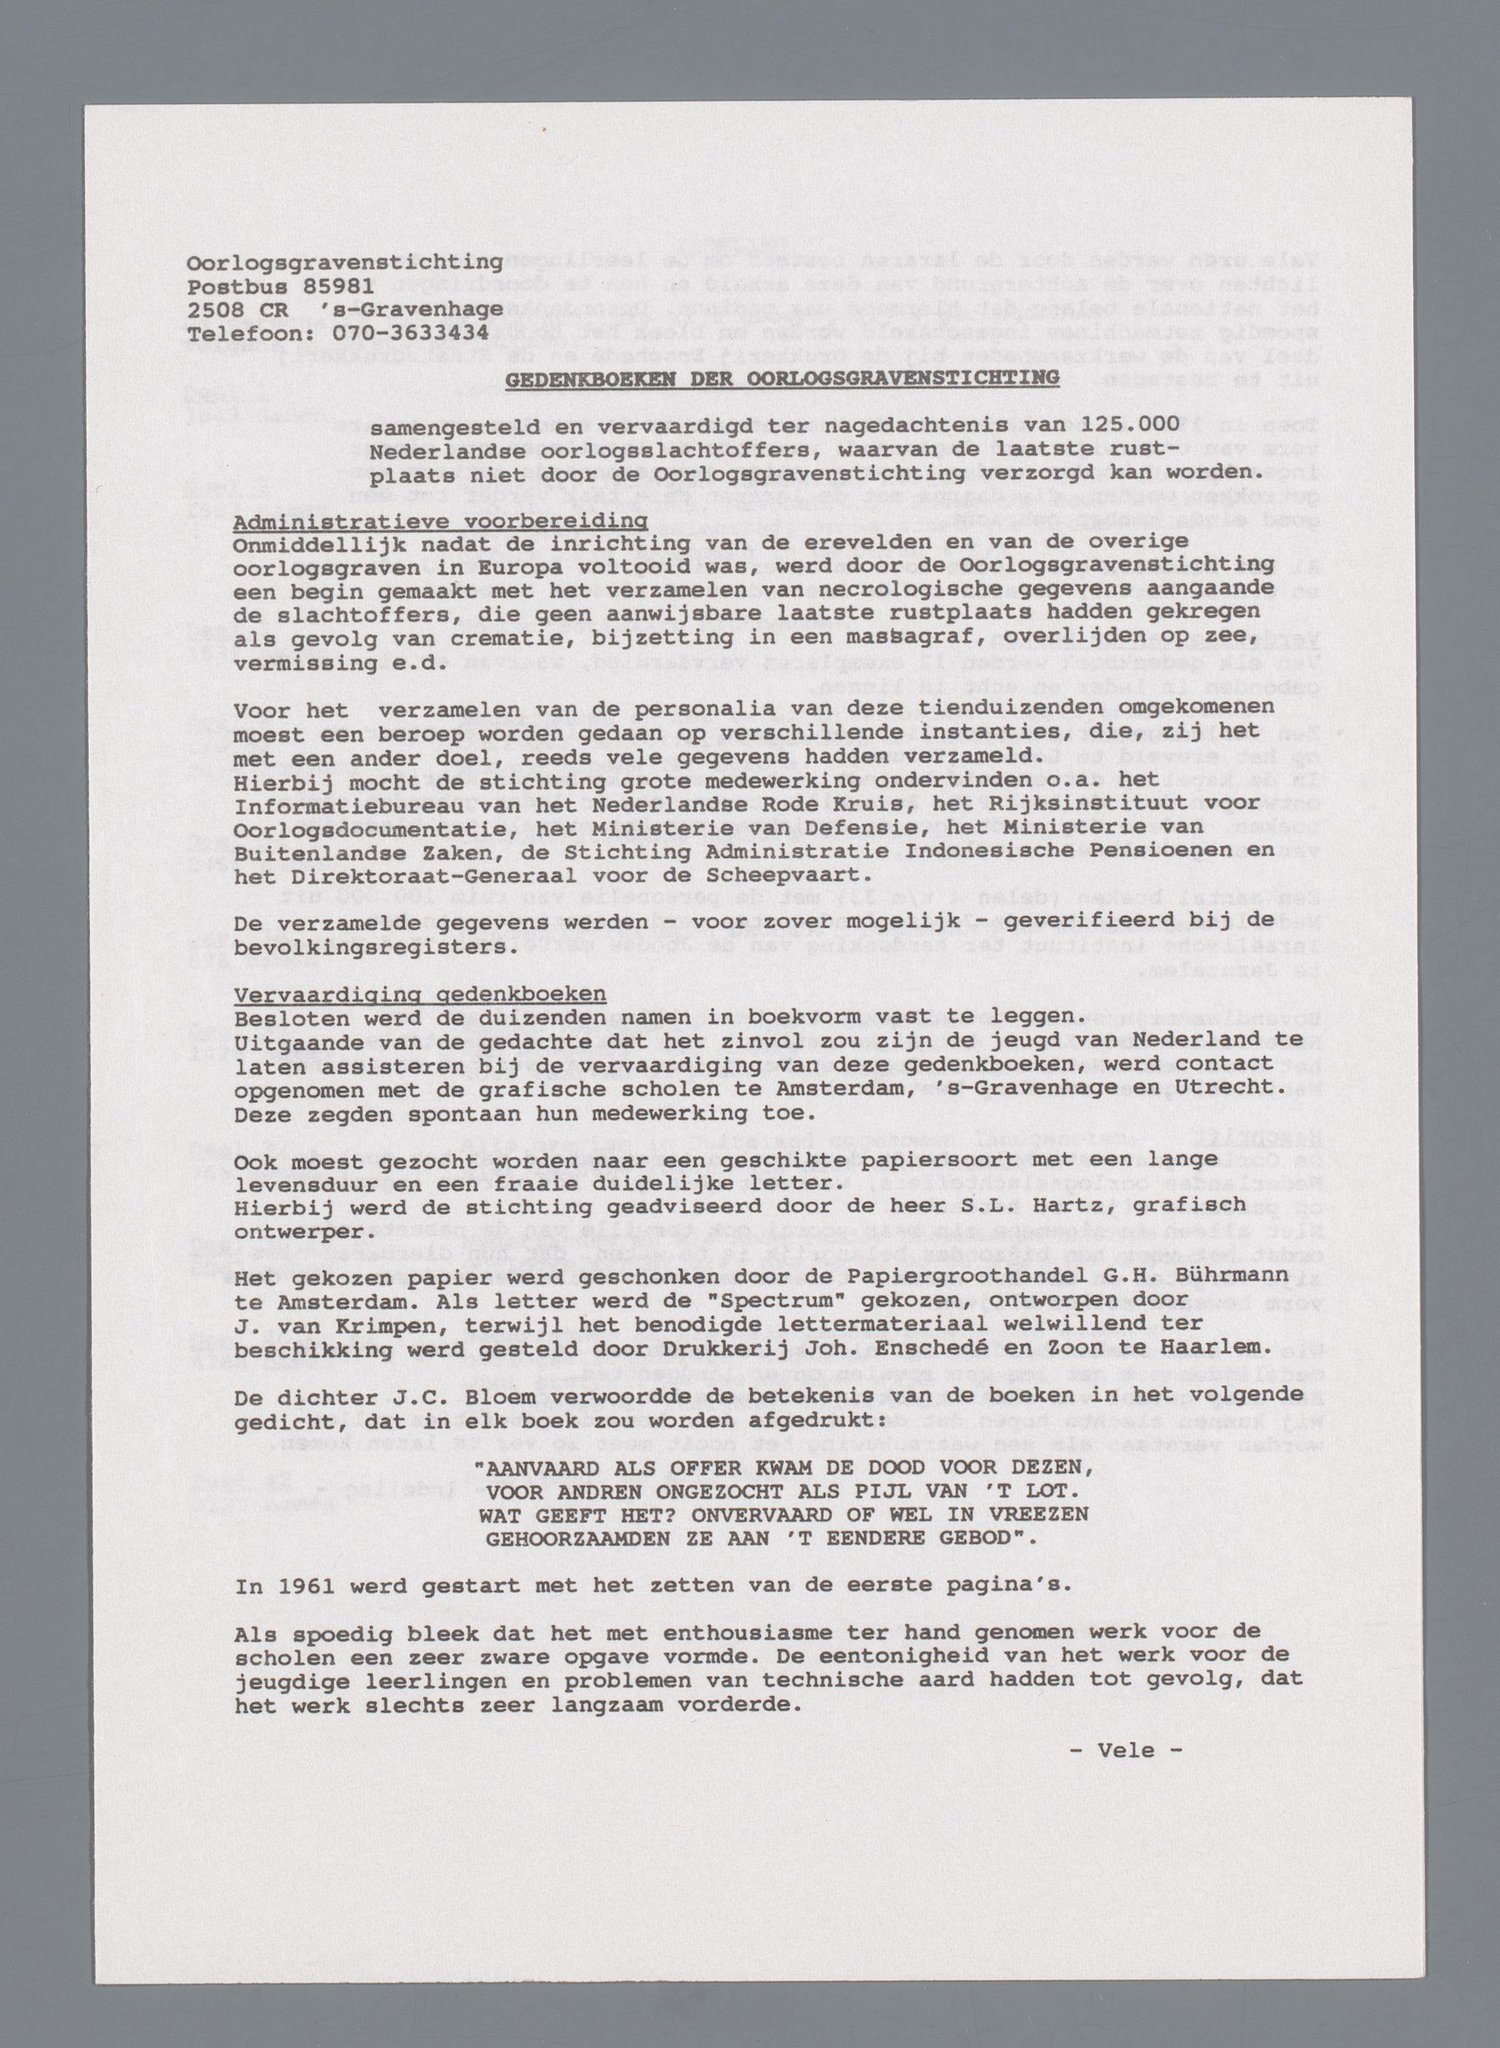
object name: document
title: Documenten met daarin de oorlogservaringen van Isabel Wachenheimer en de verwerking daarvan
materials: paper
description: Dit object is onderdeel van de nalatenschap van Isabel Elon-Wachenheimer (1928-2010). Tot haar overlijden behoorde het samen met de andere objecten uit de nalatenschap tot haar privédomein van Isabel Wachenheimer. In die particuliere context zijn deze objecten tezamen en individueel aandenkens - aan de jeugd, ouders en familie van Isabel Wachenheimer vóór en tijdens de Shoah en aan haar leven na de Tweede Wereldoorlog. Isabel Wachenheimer, die van juni 1943 tot mei 1945 gevangen zat in Kamp Westerbork, Theresienstadt, Auschwitz, Lenzing a/d Oberdonau (een buitenkamp van Mauthausen), overleefde de Shoah. Haar ouders – Eugène Wachenheimer en Else Wachenheimer-Moos - werden op 14 oktober 1944 in Auschwitz-Birkenau vermoord.